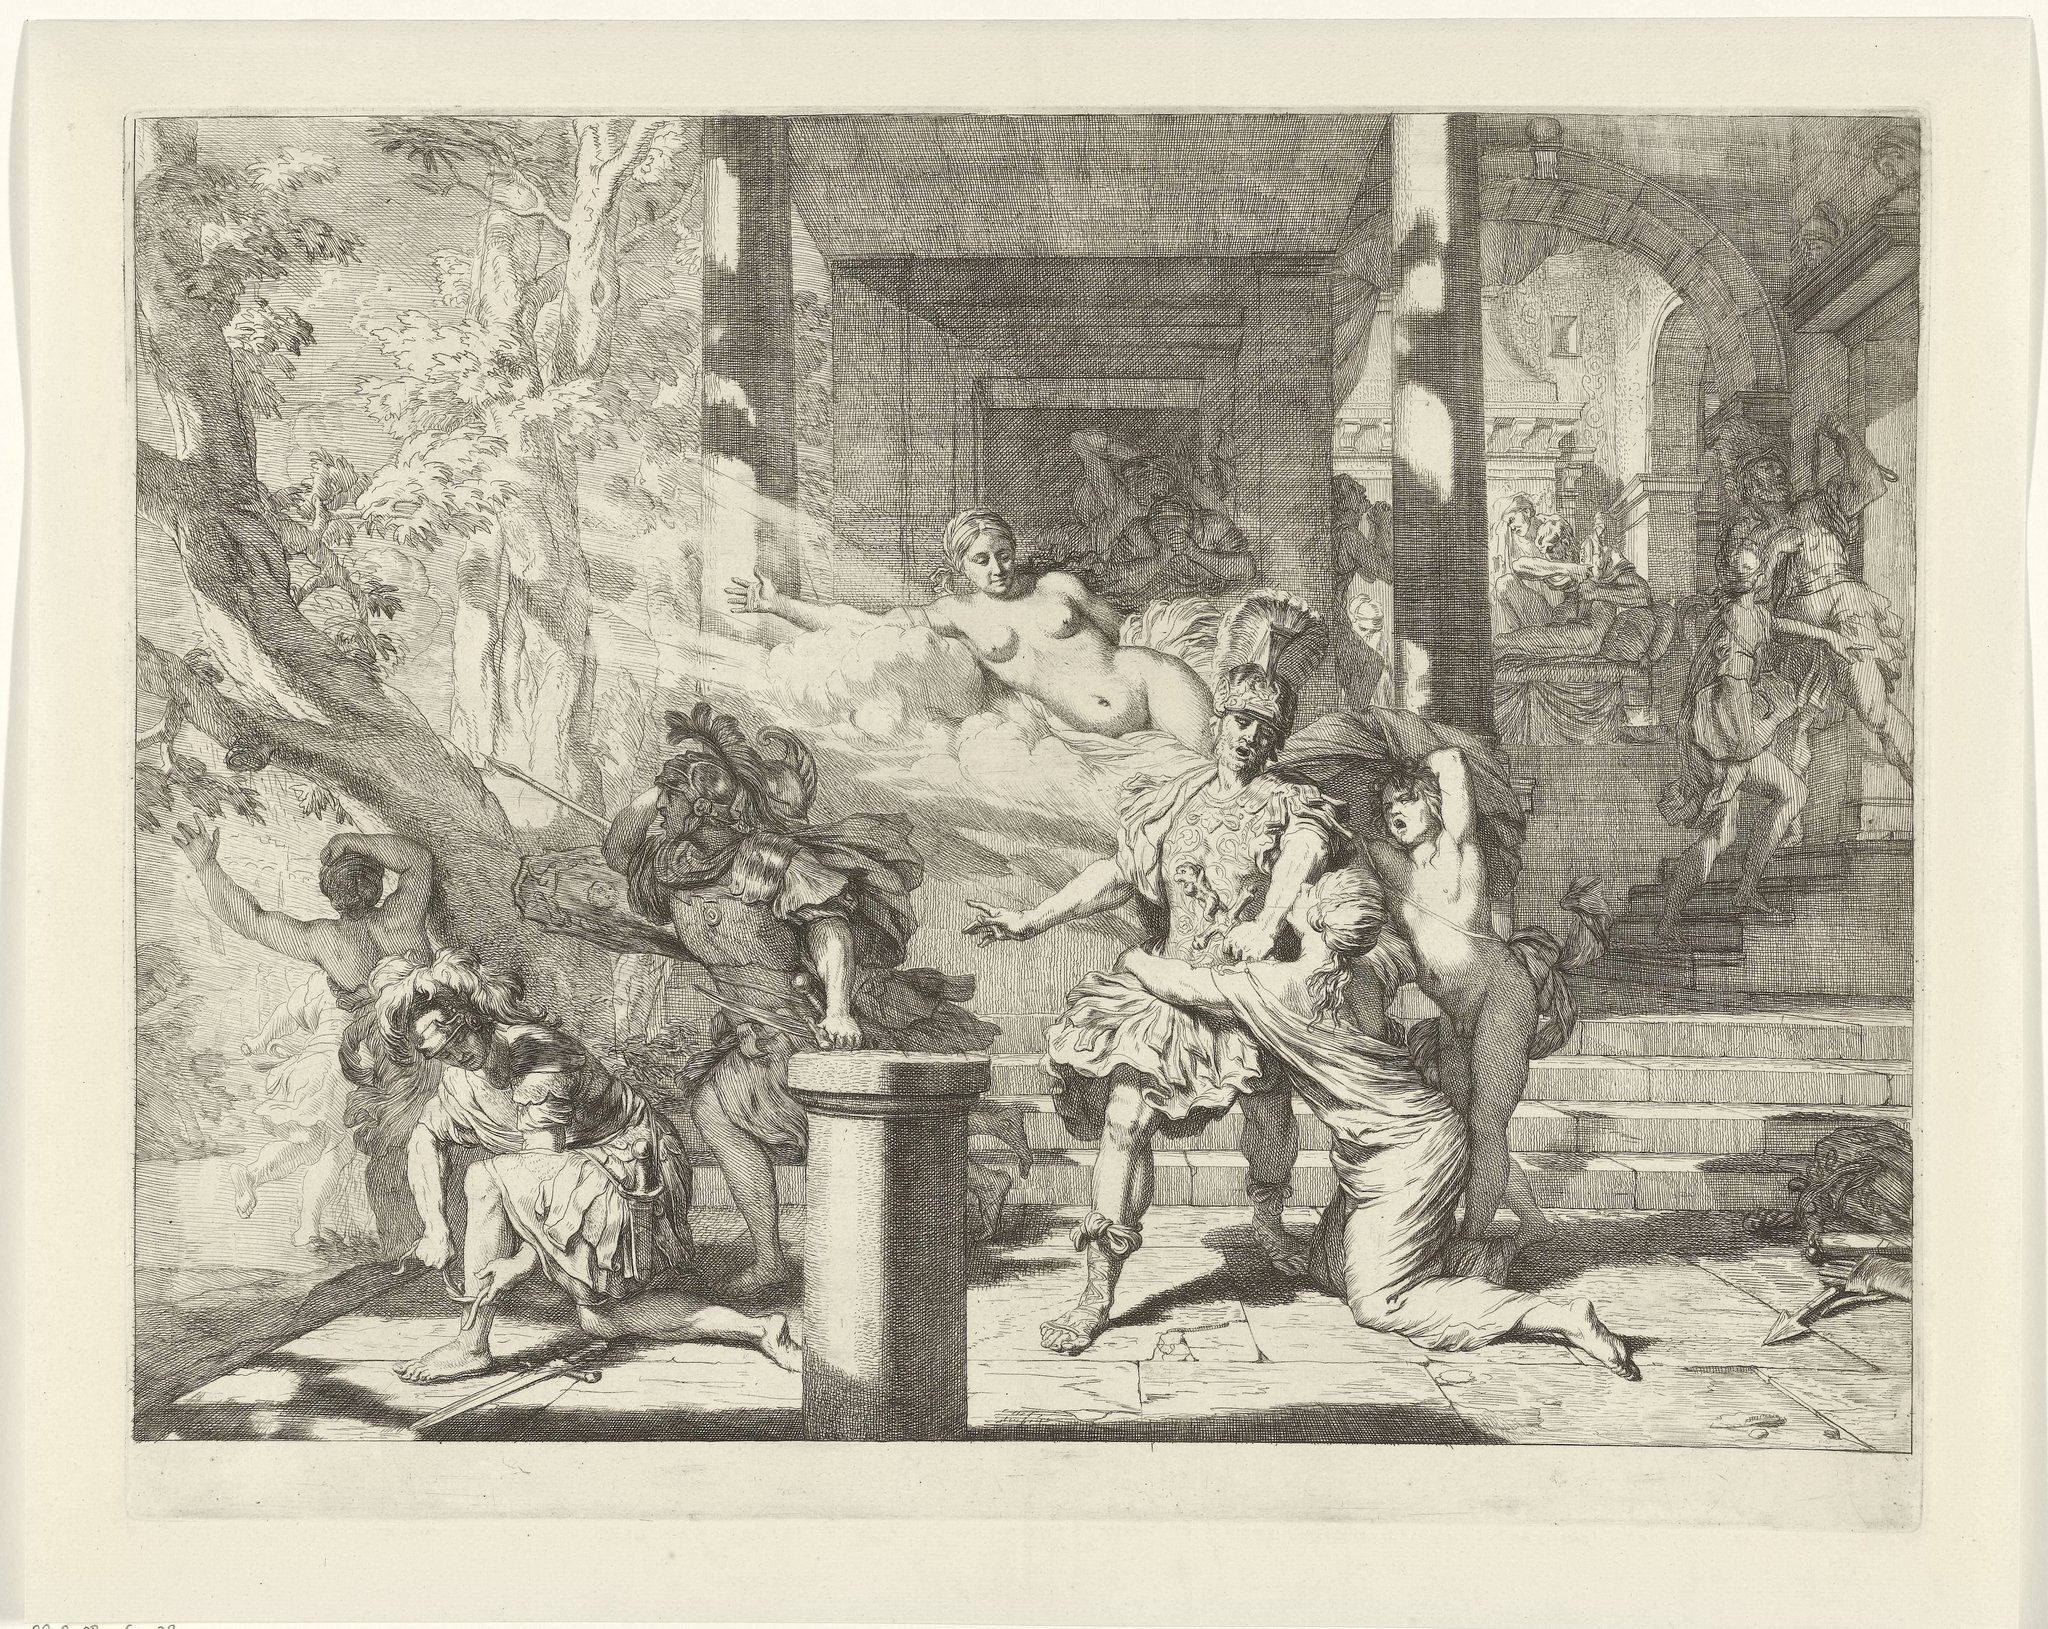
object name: print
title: Aeneas Going to Battle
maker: gerard de lairesse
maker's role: draughtsman, painter, print maker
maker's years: 1641-1711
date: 1667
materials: paper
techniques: etching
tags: (story of) aeneas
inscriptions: collector's mark: Lugt 240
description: De Lairesse’s subject matter was frequently highly idiosyncratic. This time he chose a rarely portrayed scene in the Aeneid, Vergil’s epic poem about the Trojan Aeneas. The goddess Venus, Aeneas’ mother, enjoins her son from a cloud to wage war against the Greeks. Desperate, his wife Creusa and son Ascanius, try to stop him. To no avail, naturally.